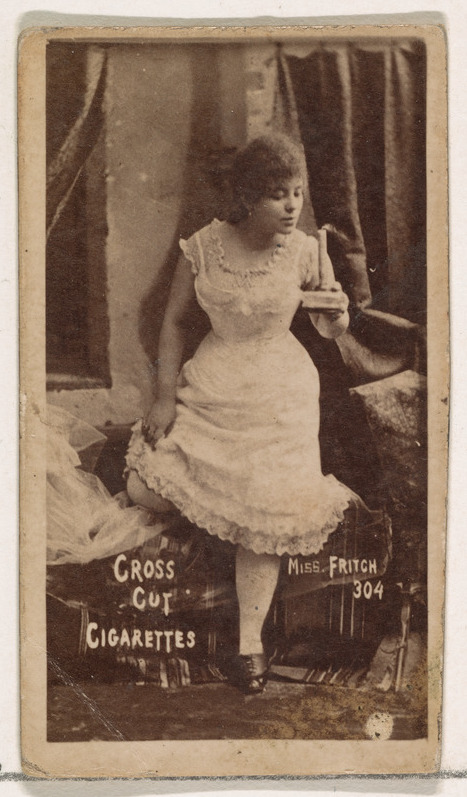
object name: print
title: Card Number 304, Miss Fritch, from the Actors and Actresses series (N145-1) issued by Duke Sons & Co. to promote Cross Cut Cigarettes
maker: w. duke, sons & co.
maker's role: publisher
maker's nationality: american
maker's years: 1870-1920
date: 1880-1889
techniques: albumen silver print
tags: portraits,women,actresses